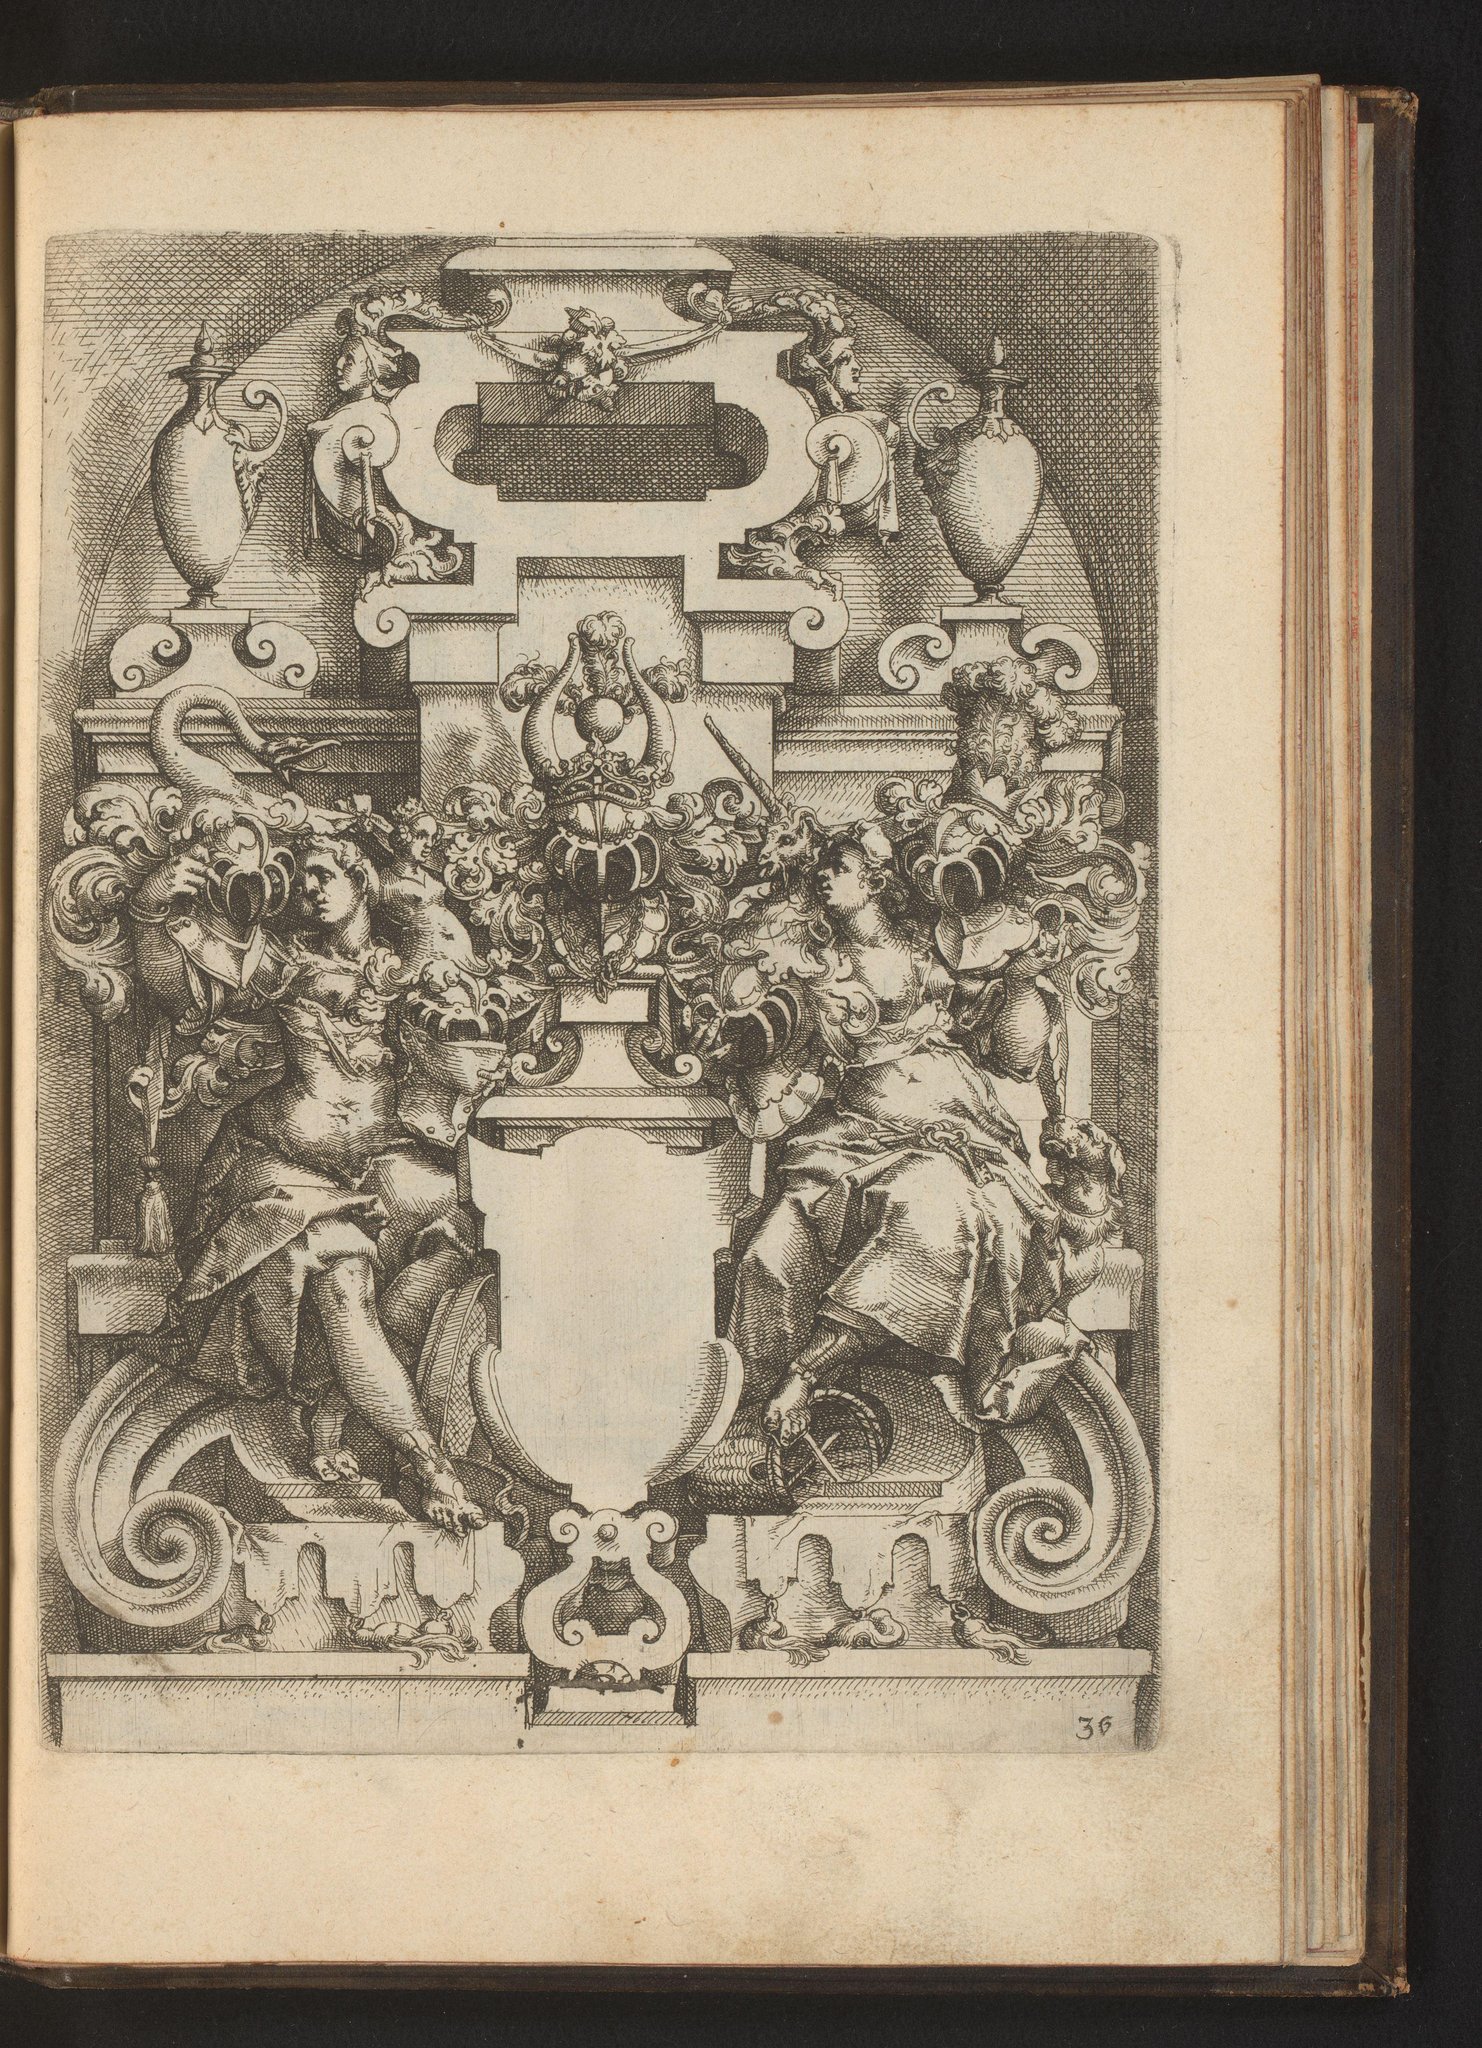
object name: ornament print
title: Cartouche geflankeerd door twee vrouwen, een eenhoorn en een zwaan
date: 1593-1595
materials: paper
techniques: etching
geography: straatsburg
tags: parts of church exterior and annexes: portal, unicorn, ornament ~ cartouche, ornament derived from architectural details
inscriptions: collector's mark: Lugt 2228, collector's mark: Lugt 2760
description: Prent gebruikt in: Dietterlin, Wendel (I). Wendel Dietterlin, Architectura de Polstium seu Portalium ornatu uario Liber II. Straatsburg: Bernhard Jobin, 1594.